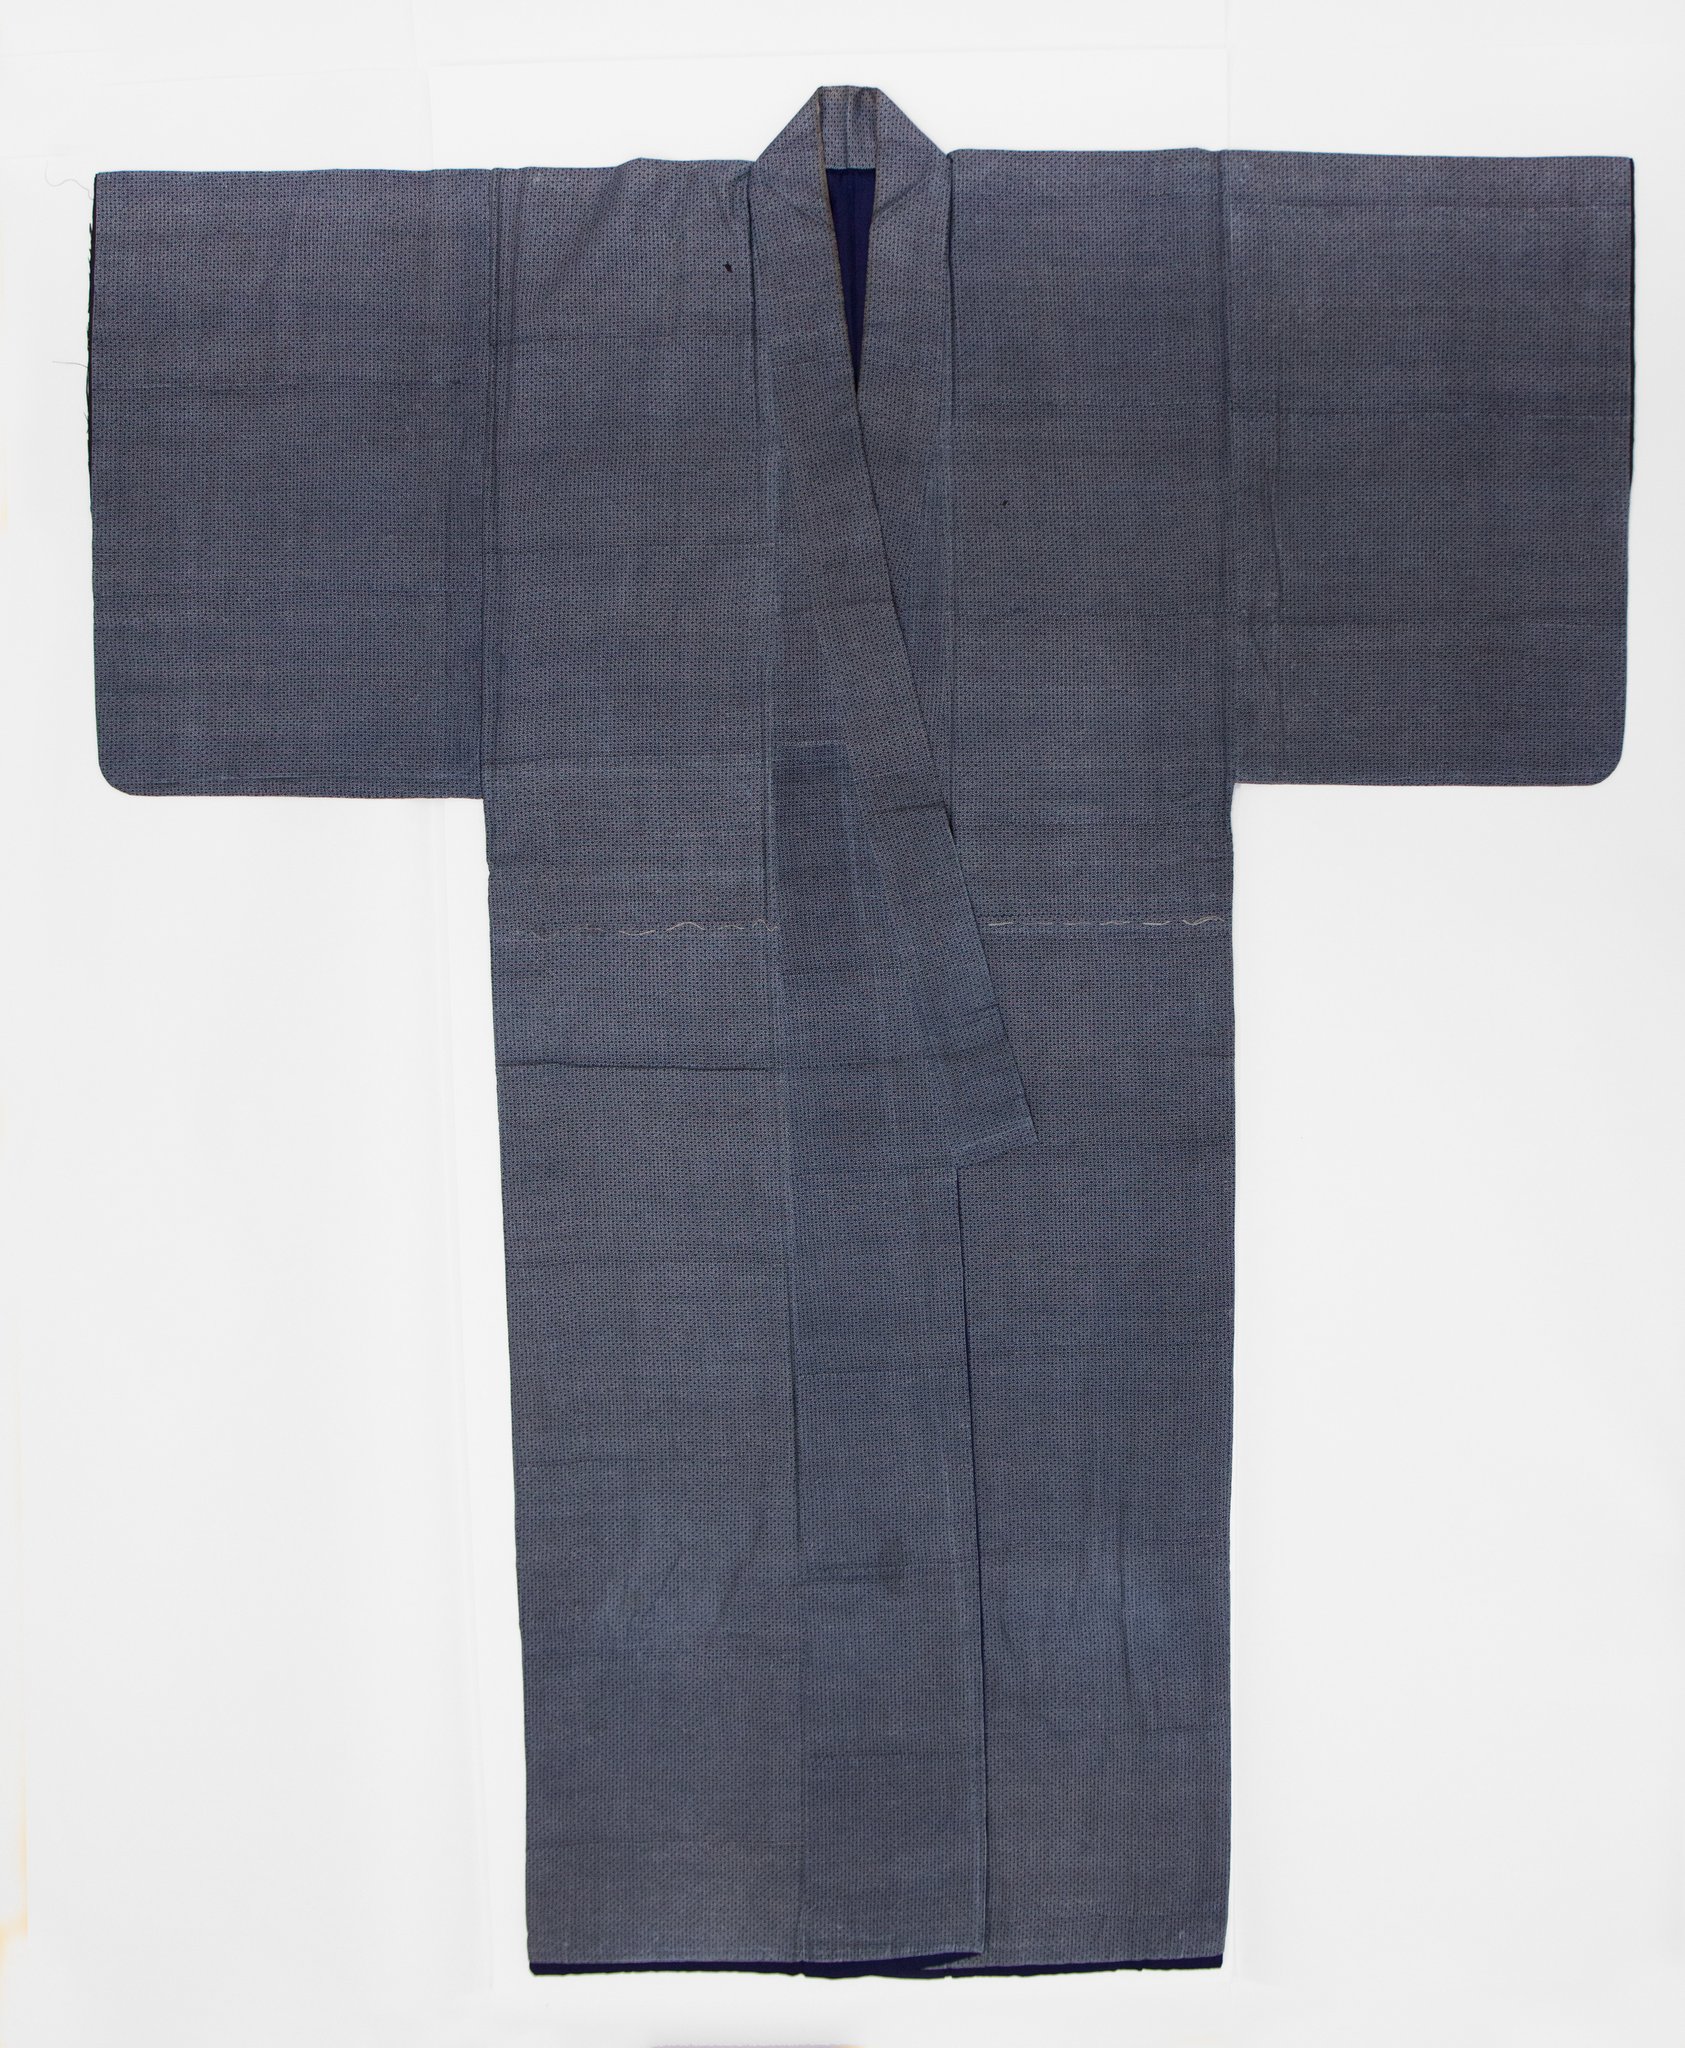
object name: kosode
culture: japanese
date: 1615-1868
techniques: dyeing, resist